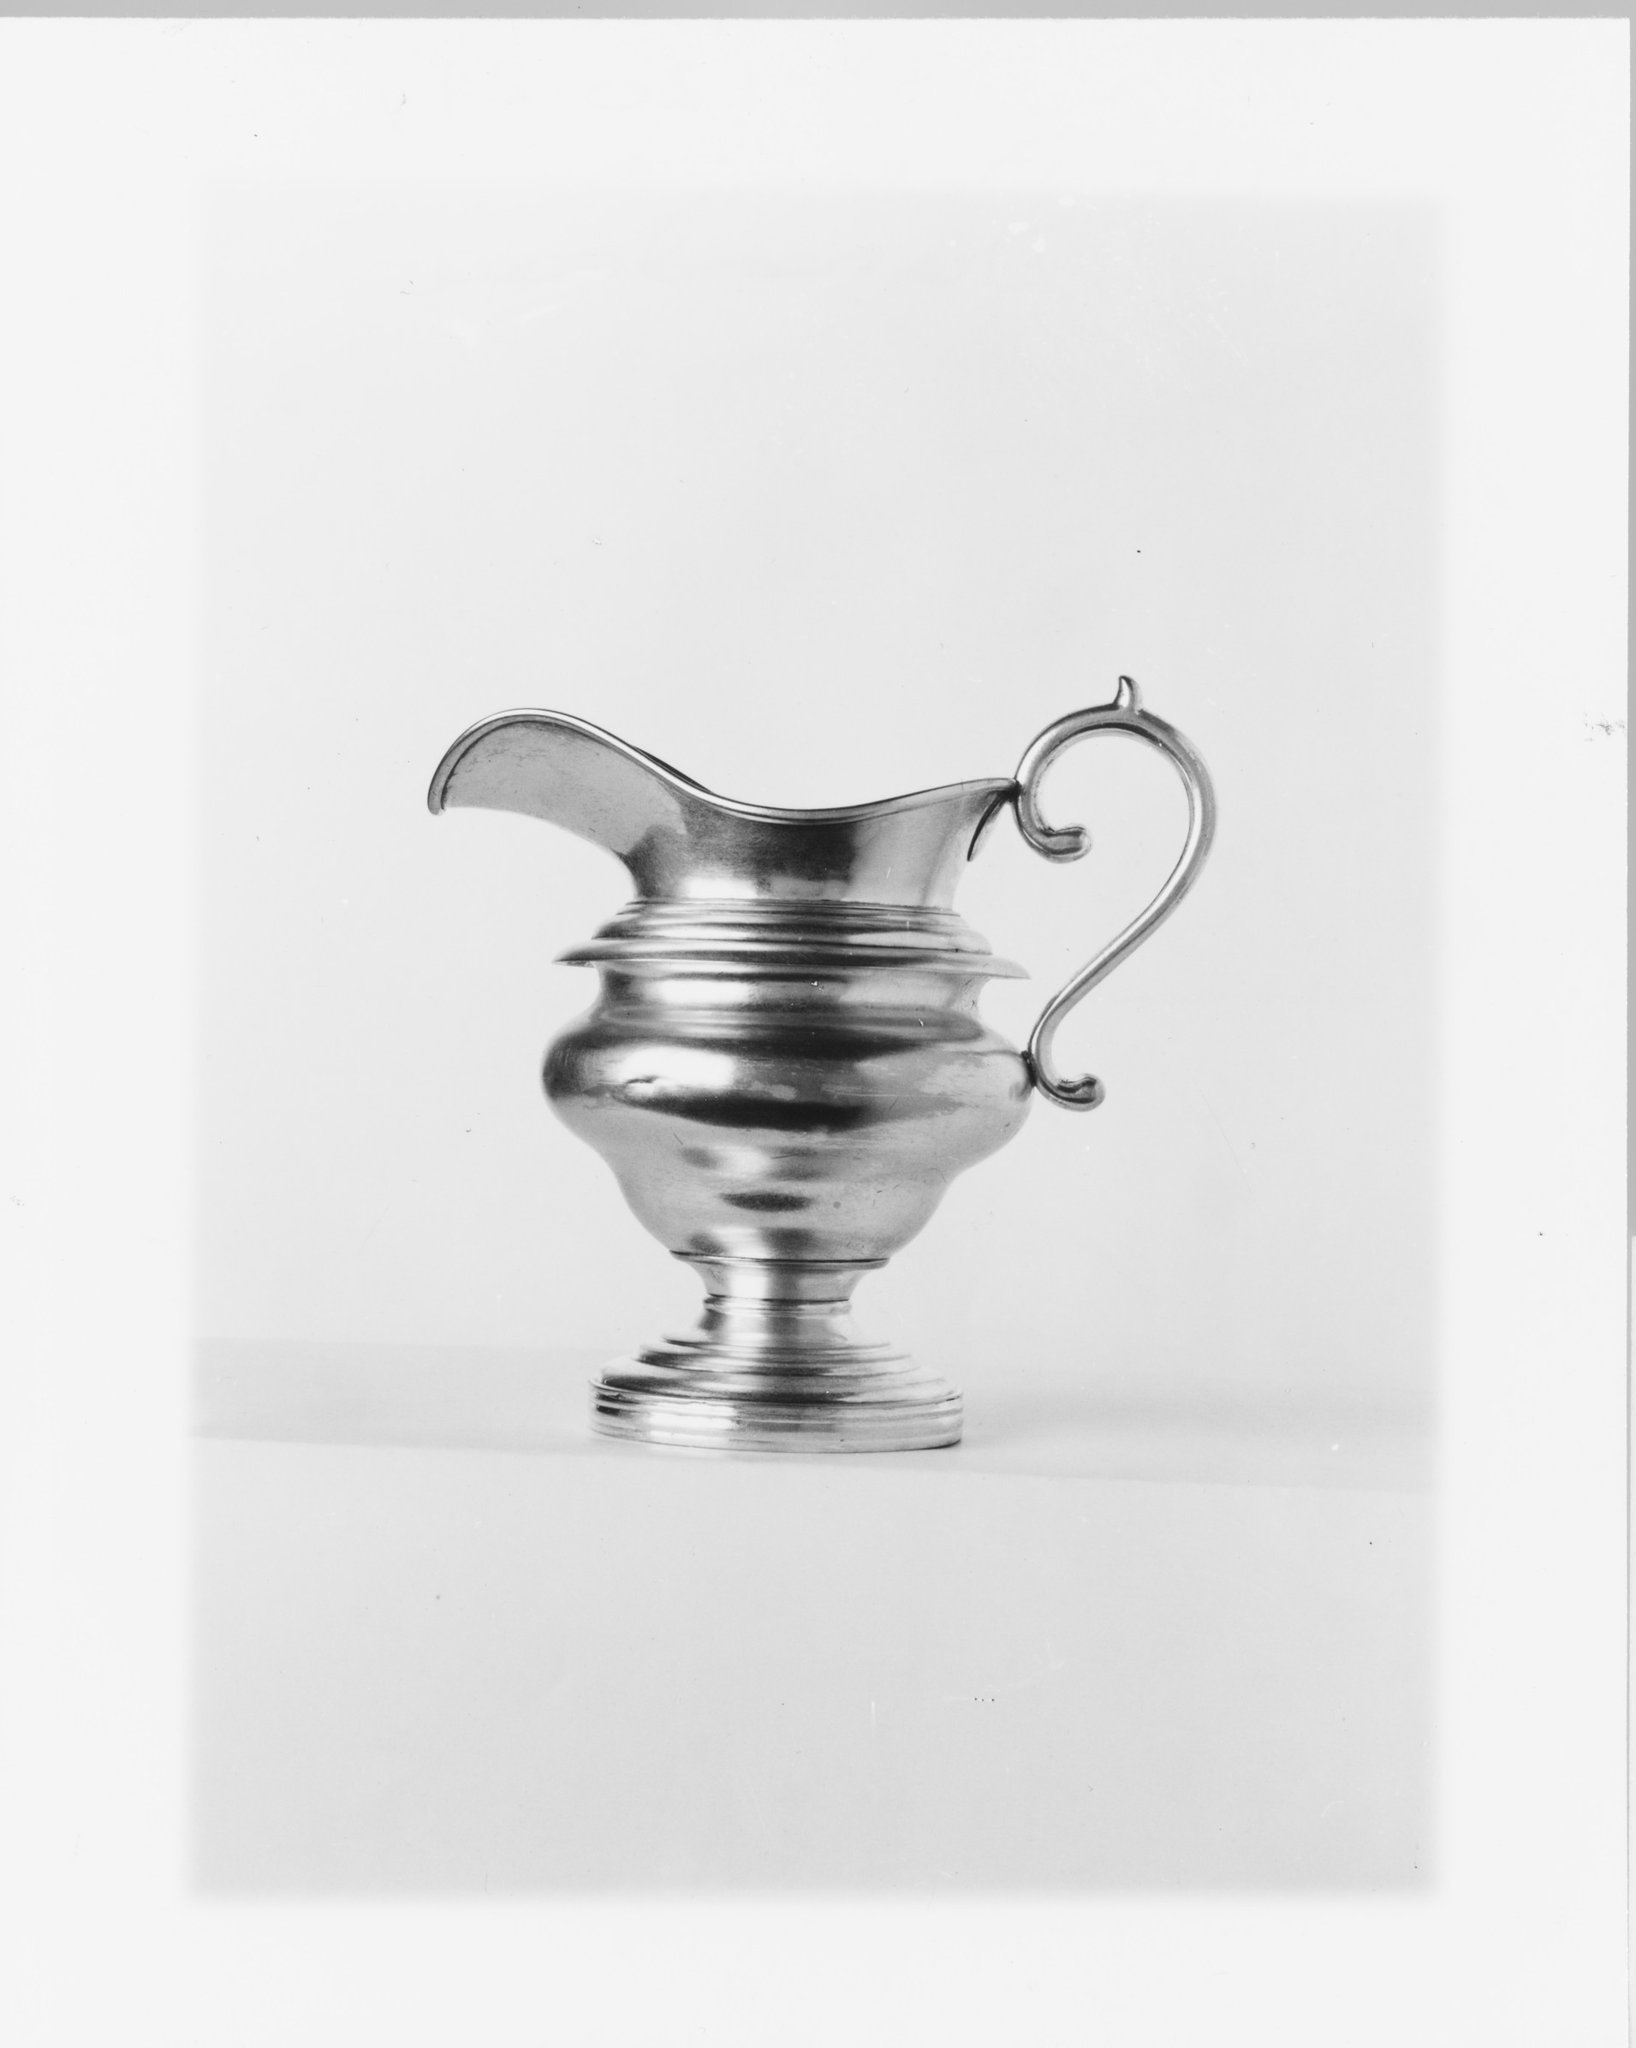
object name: cream pot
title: Creamer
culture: american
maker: belloni and durandeau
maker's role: maker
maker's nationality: american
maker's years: 1785-1885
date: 1835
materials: silver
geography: united states